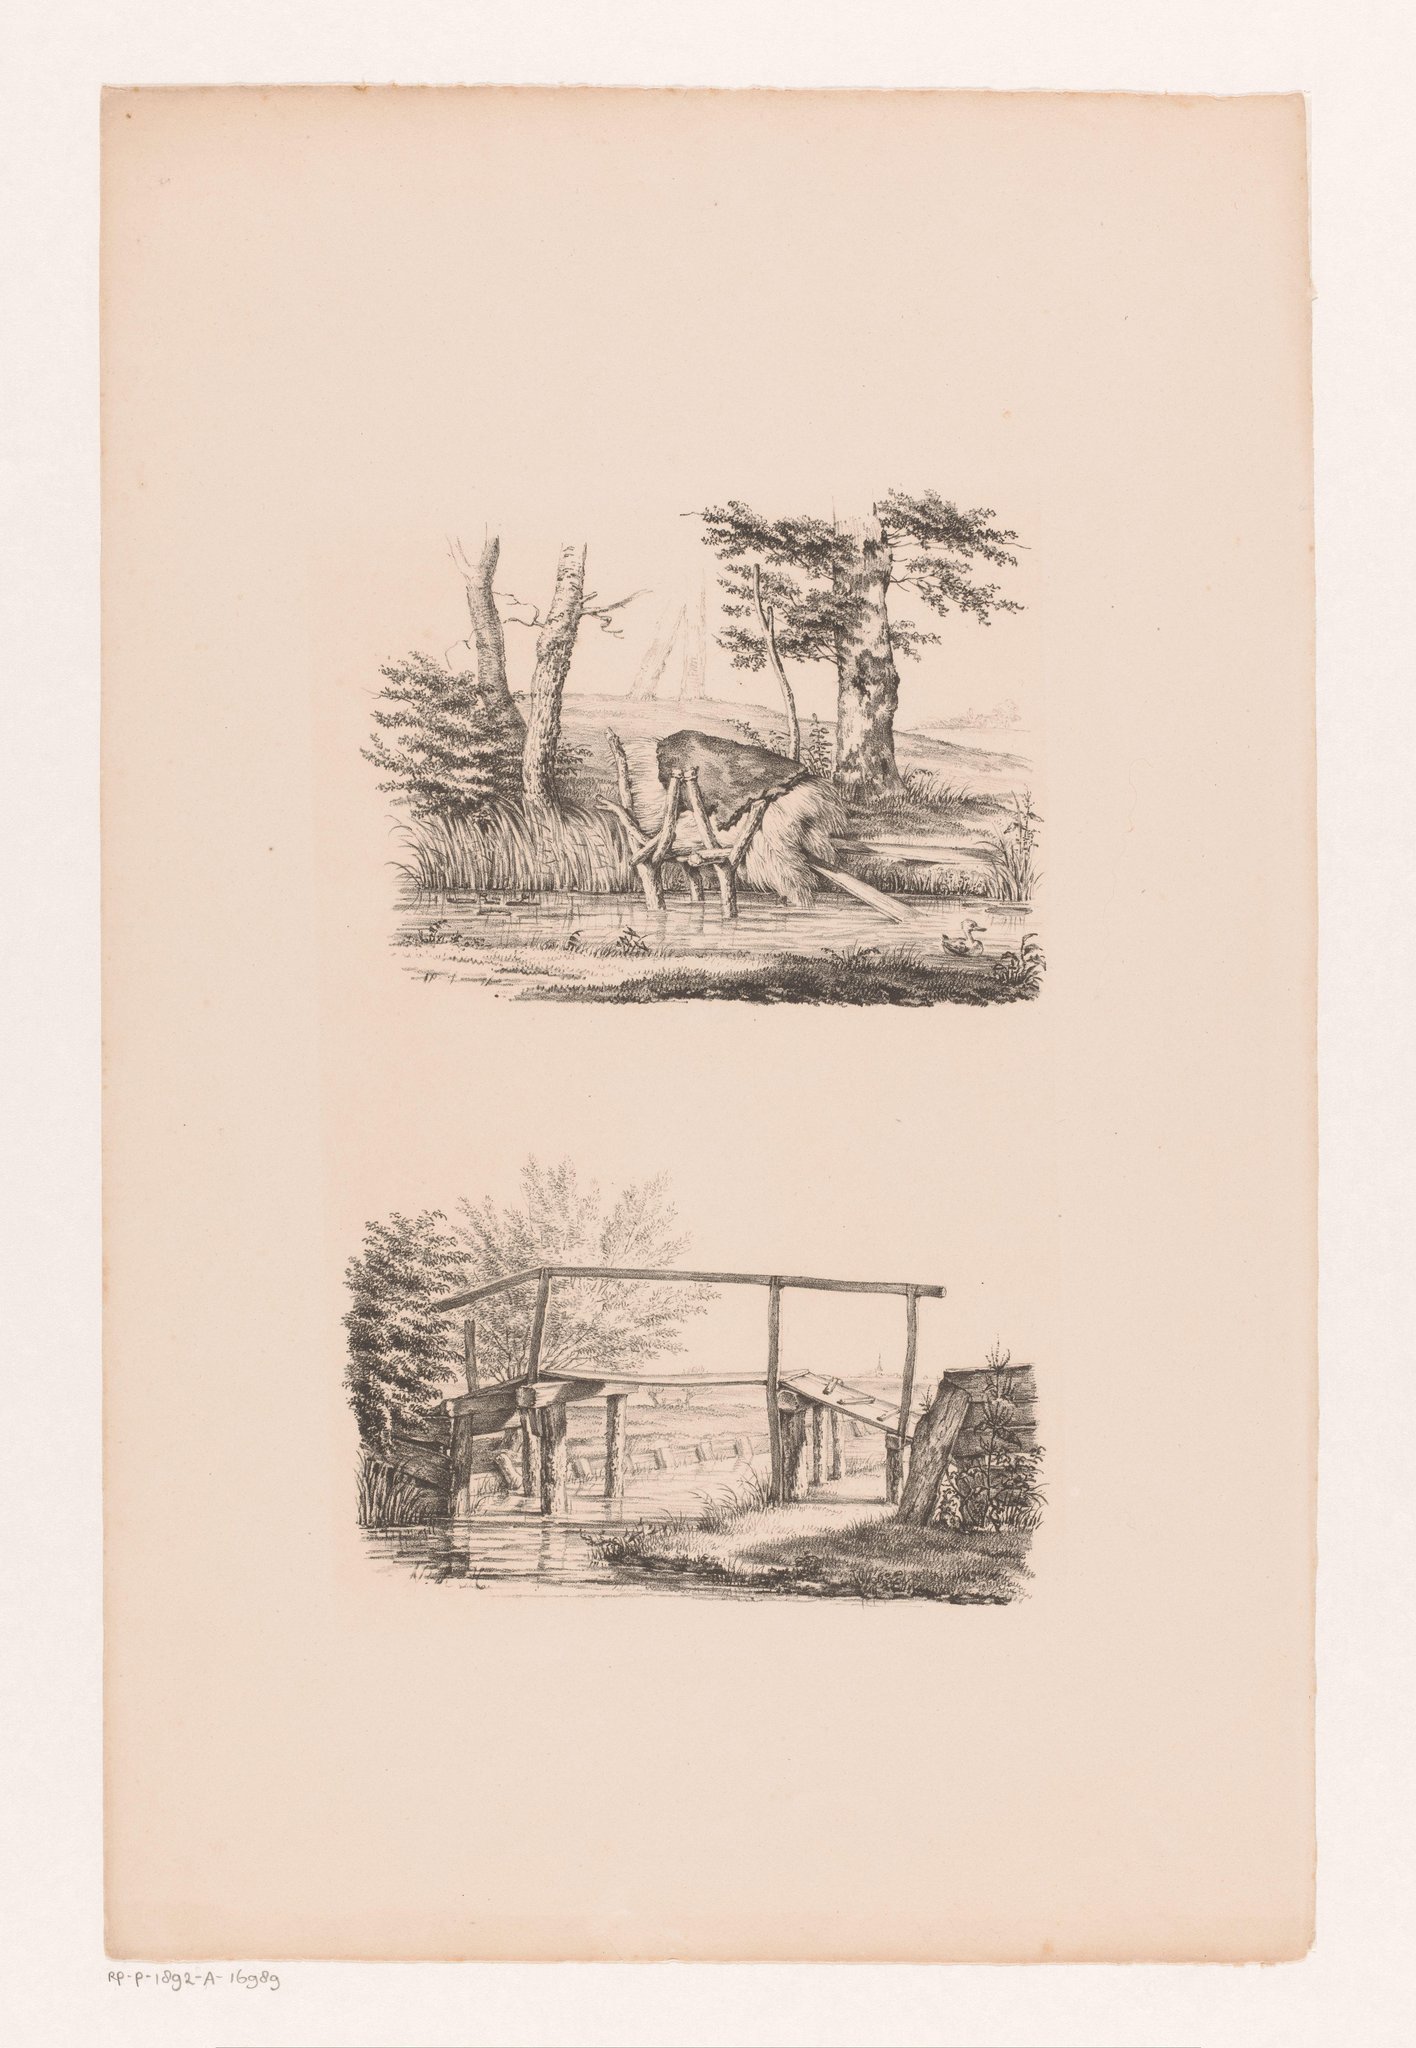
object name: print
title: Eendenkooi en een smalle loopbrug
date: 1803-1877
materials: paper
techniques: lithograph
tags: pond, small canal, ditch, water-birds: duck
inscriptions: collector's mark: Lugt 2228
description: De eendenkooi of broedplaats bevindt zich aan de rand van een vijver.